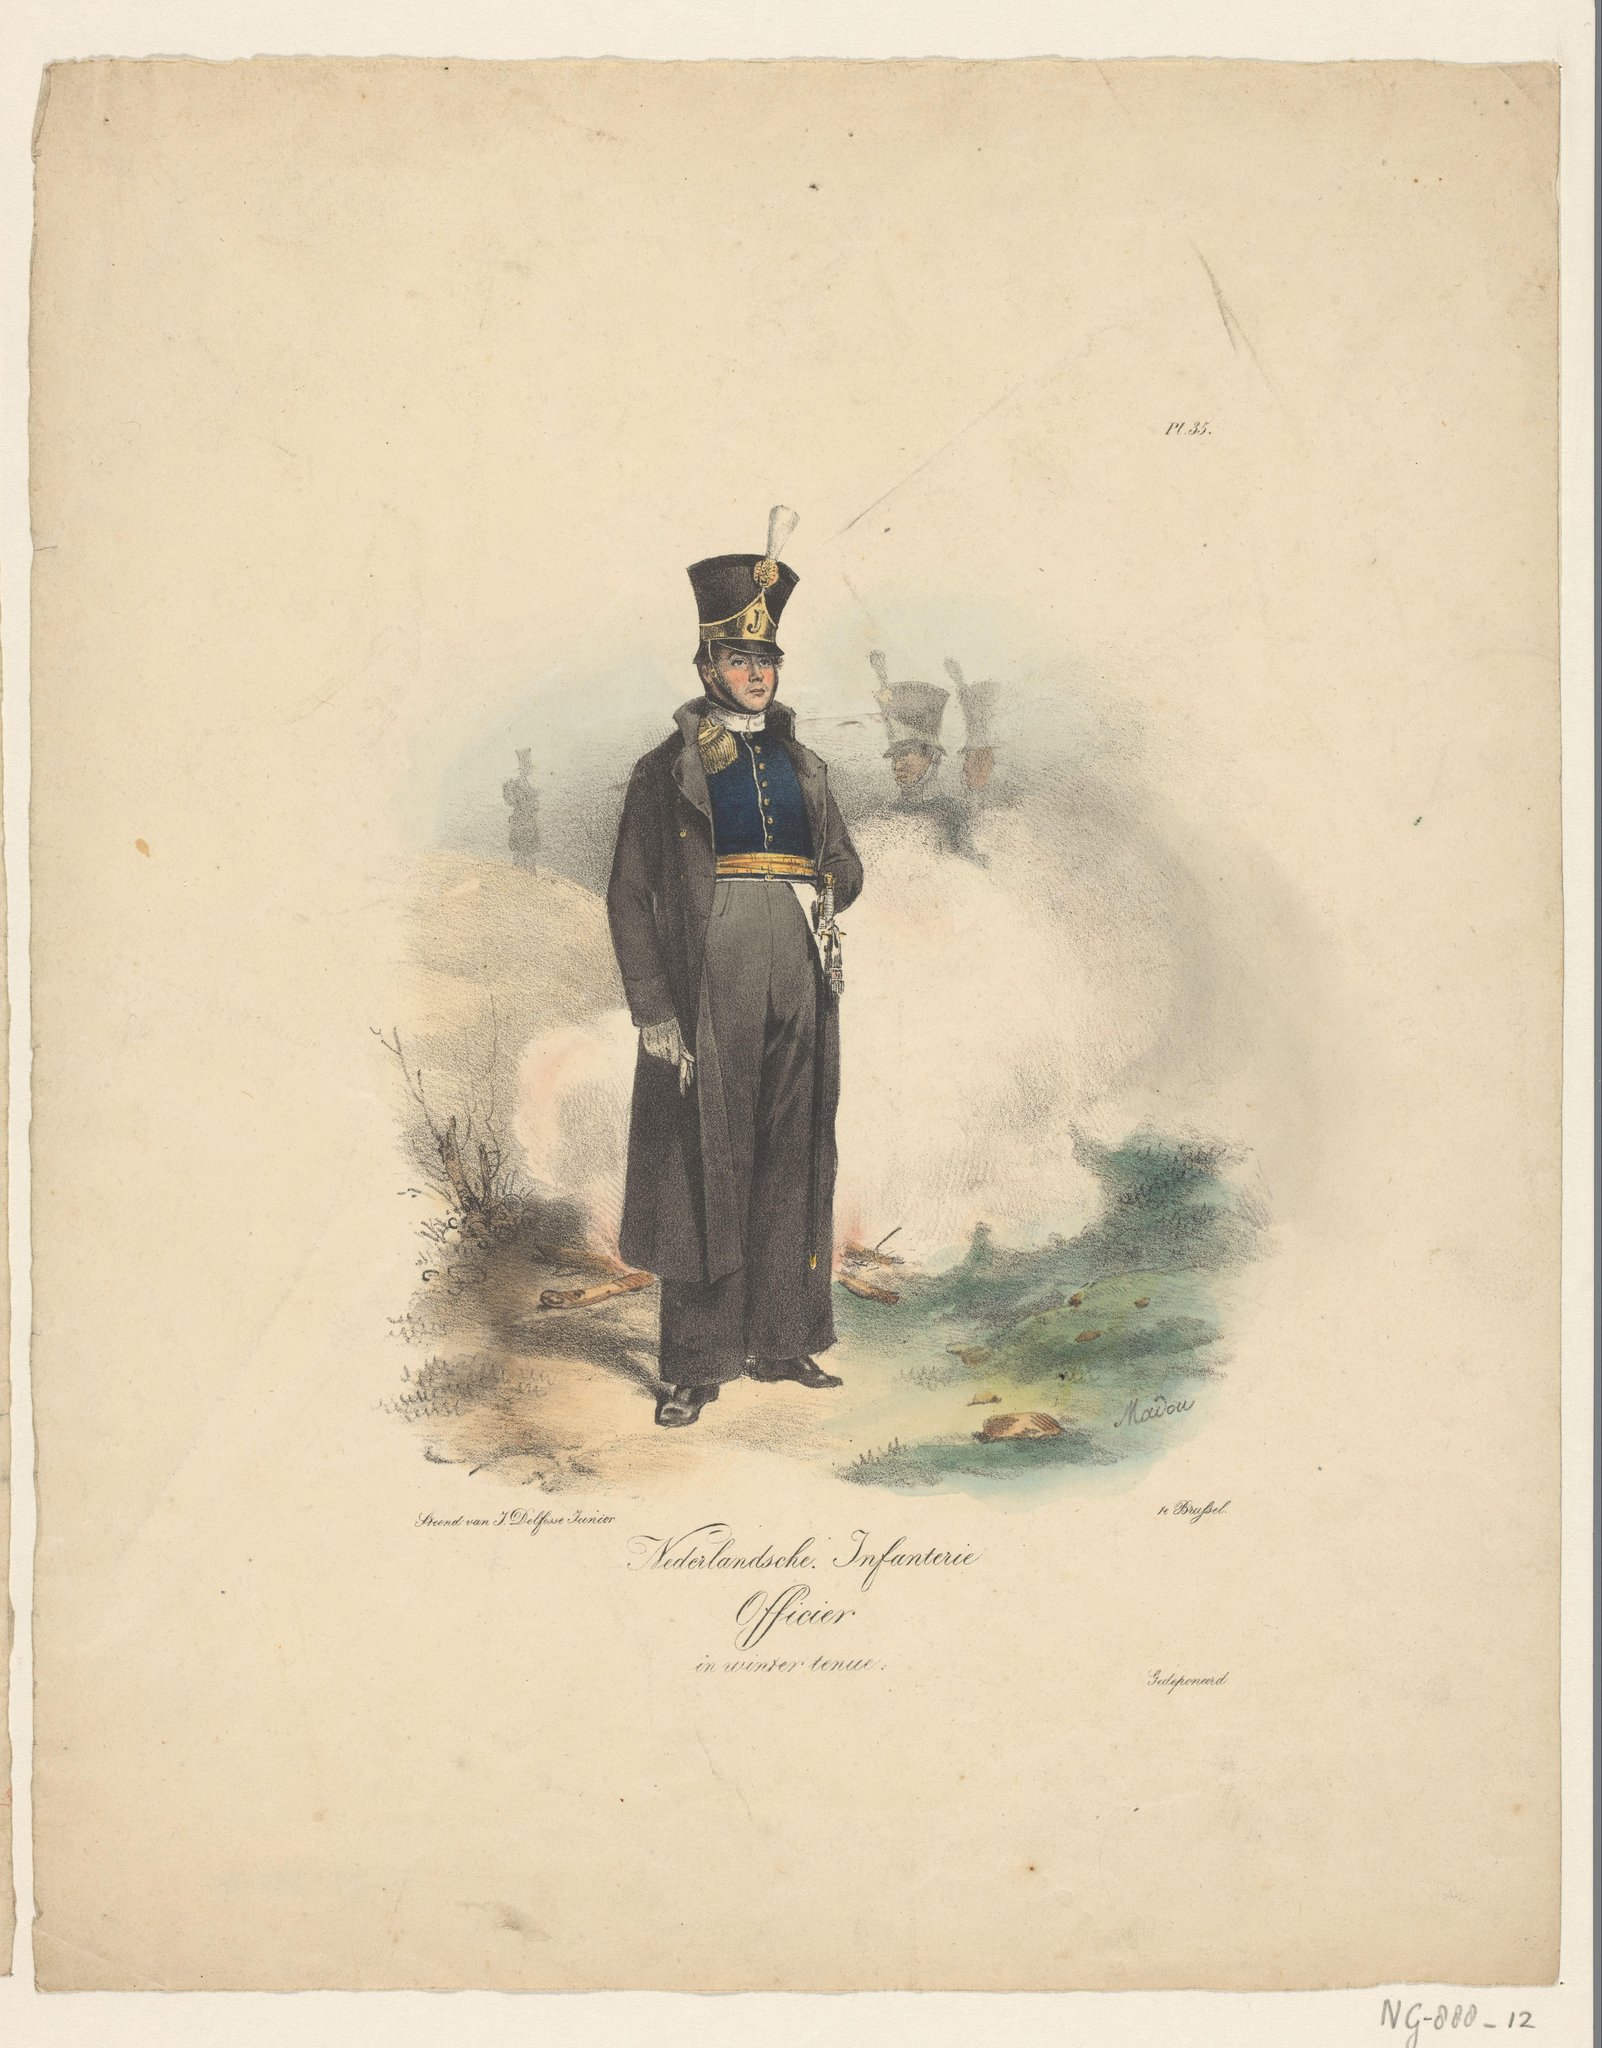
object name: costume print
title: Militaire costumen van het Koninkryk der Nederlanden : opgedragen aan zyne excellentie Willem van Bylandt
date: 1823-1827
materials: paper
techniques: hand coloring, lithograph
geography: brussels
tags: (military) uniforms (+ infantry)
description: Gebruikt als illustratie in: Militaire costumen van het Koninkryk der Nederlanden : opgedragen aan zyne excellentie Willem van Bylandt. Brussel, ca. 1825.